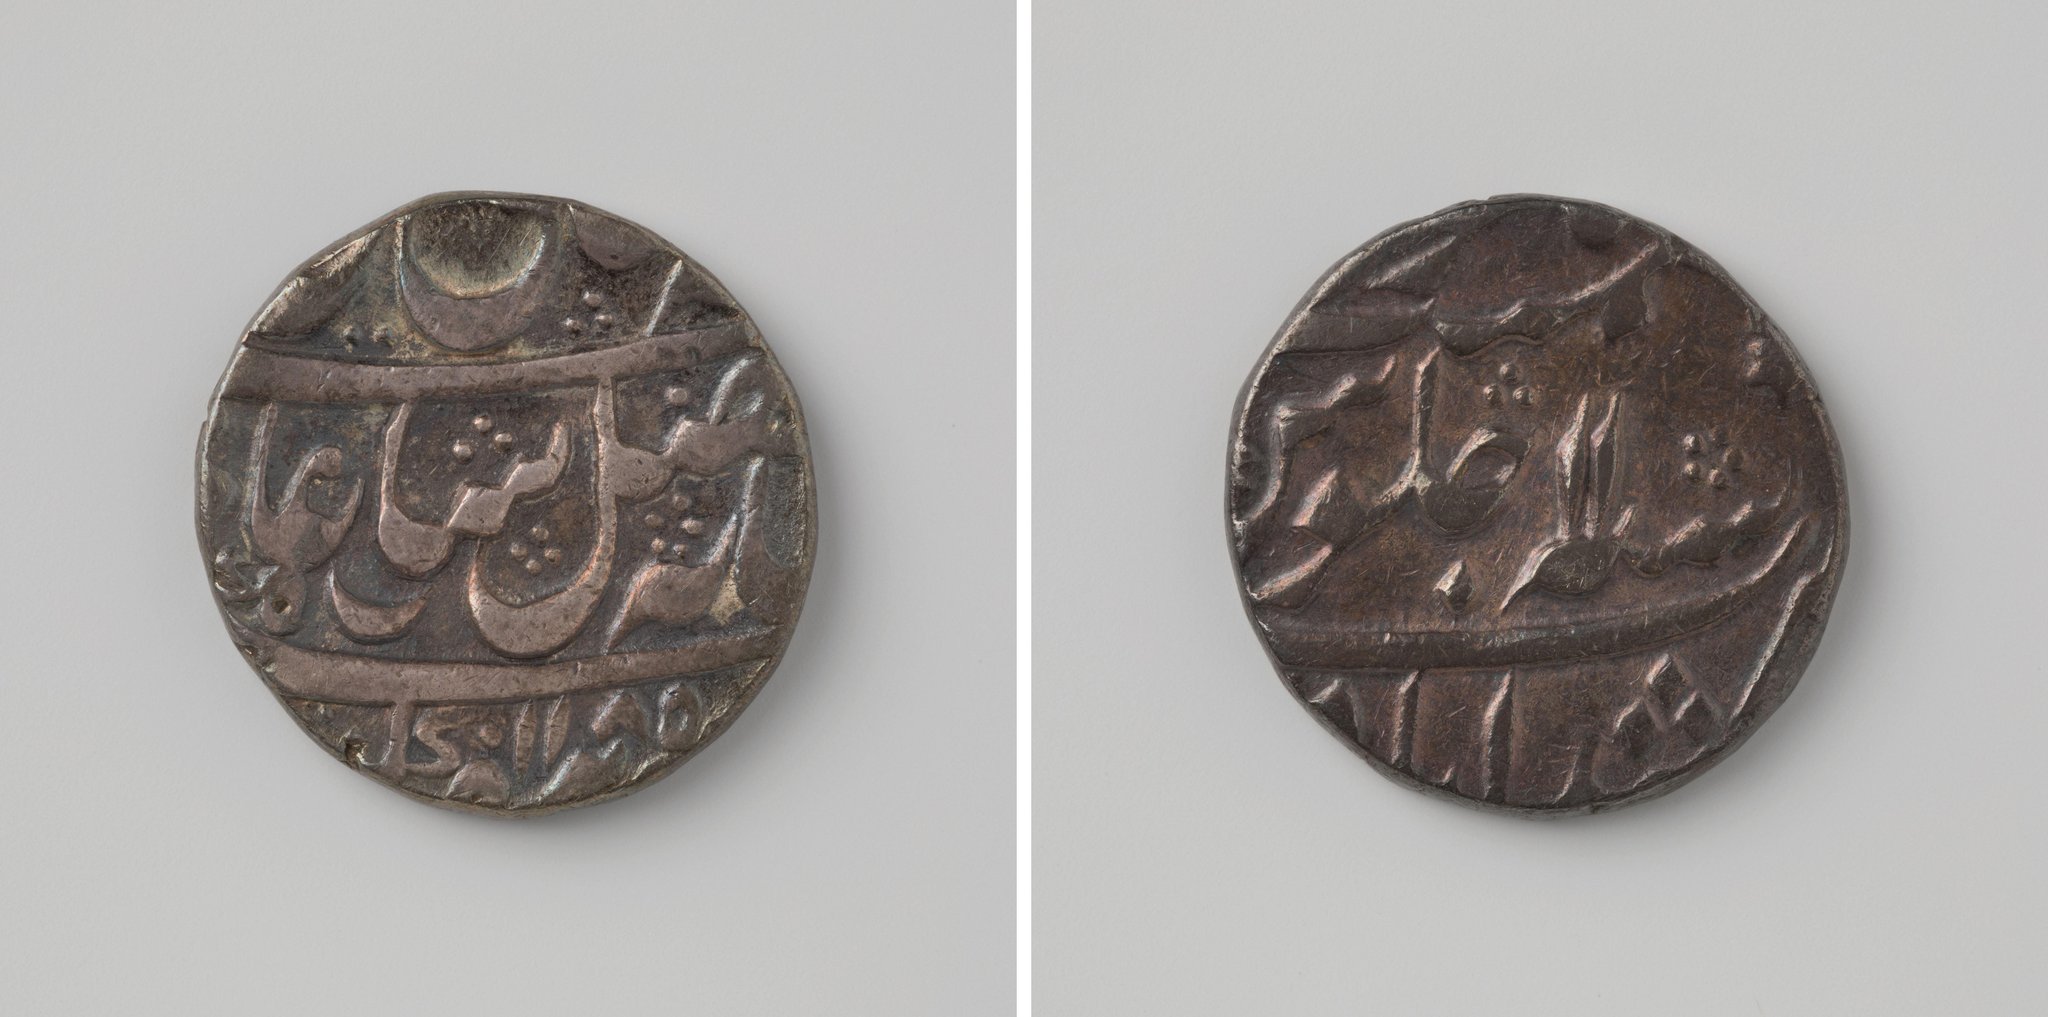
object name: coin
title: Roepie uit Bengalen in India van de Engelse Oostindische Compagnie (EIC) op naam van sjah Alam I,1185 [=1771]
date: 1771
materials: silver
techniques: striking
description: Zilveren munt. Voorzijde: in Arabische lettertekens in drie regels opschrift met onderaan aanduiding jaartal: 1185. Keerzijde: in Arabische lettertekens in drie regels opschrift. Boven tweede regel aanduiding regeringsjaaar: 11 met uiterst rechts daarvan (gedeelte van een) ster [=muntplaats Murshidabad]. Gladde rand.